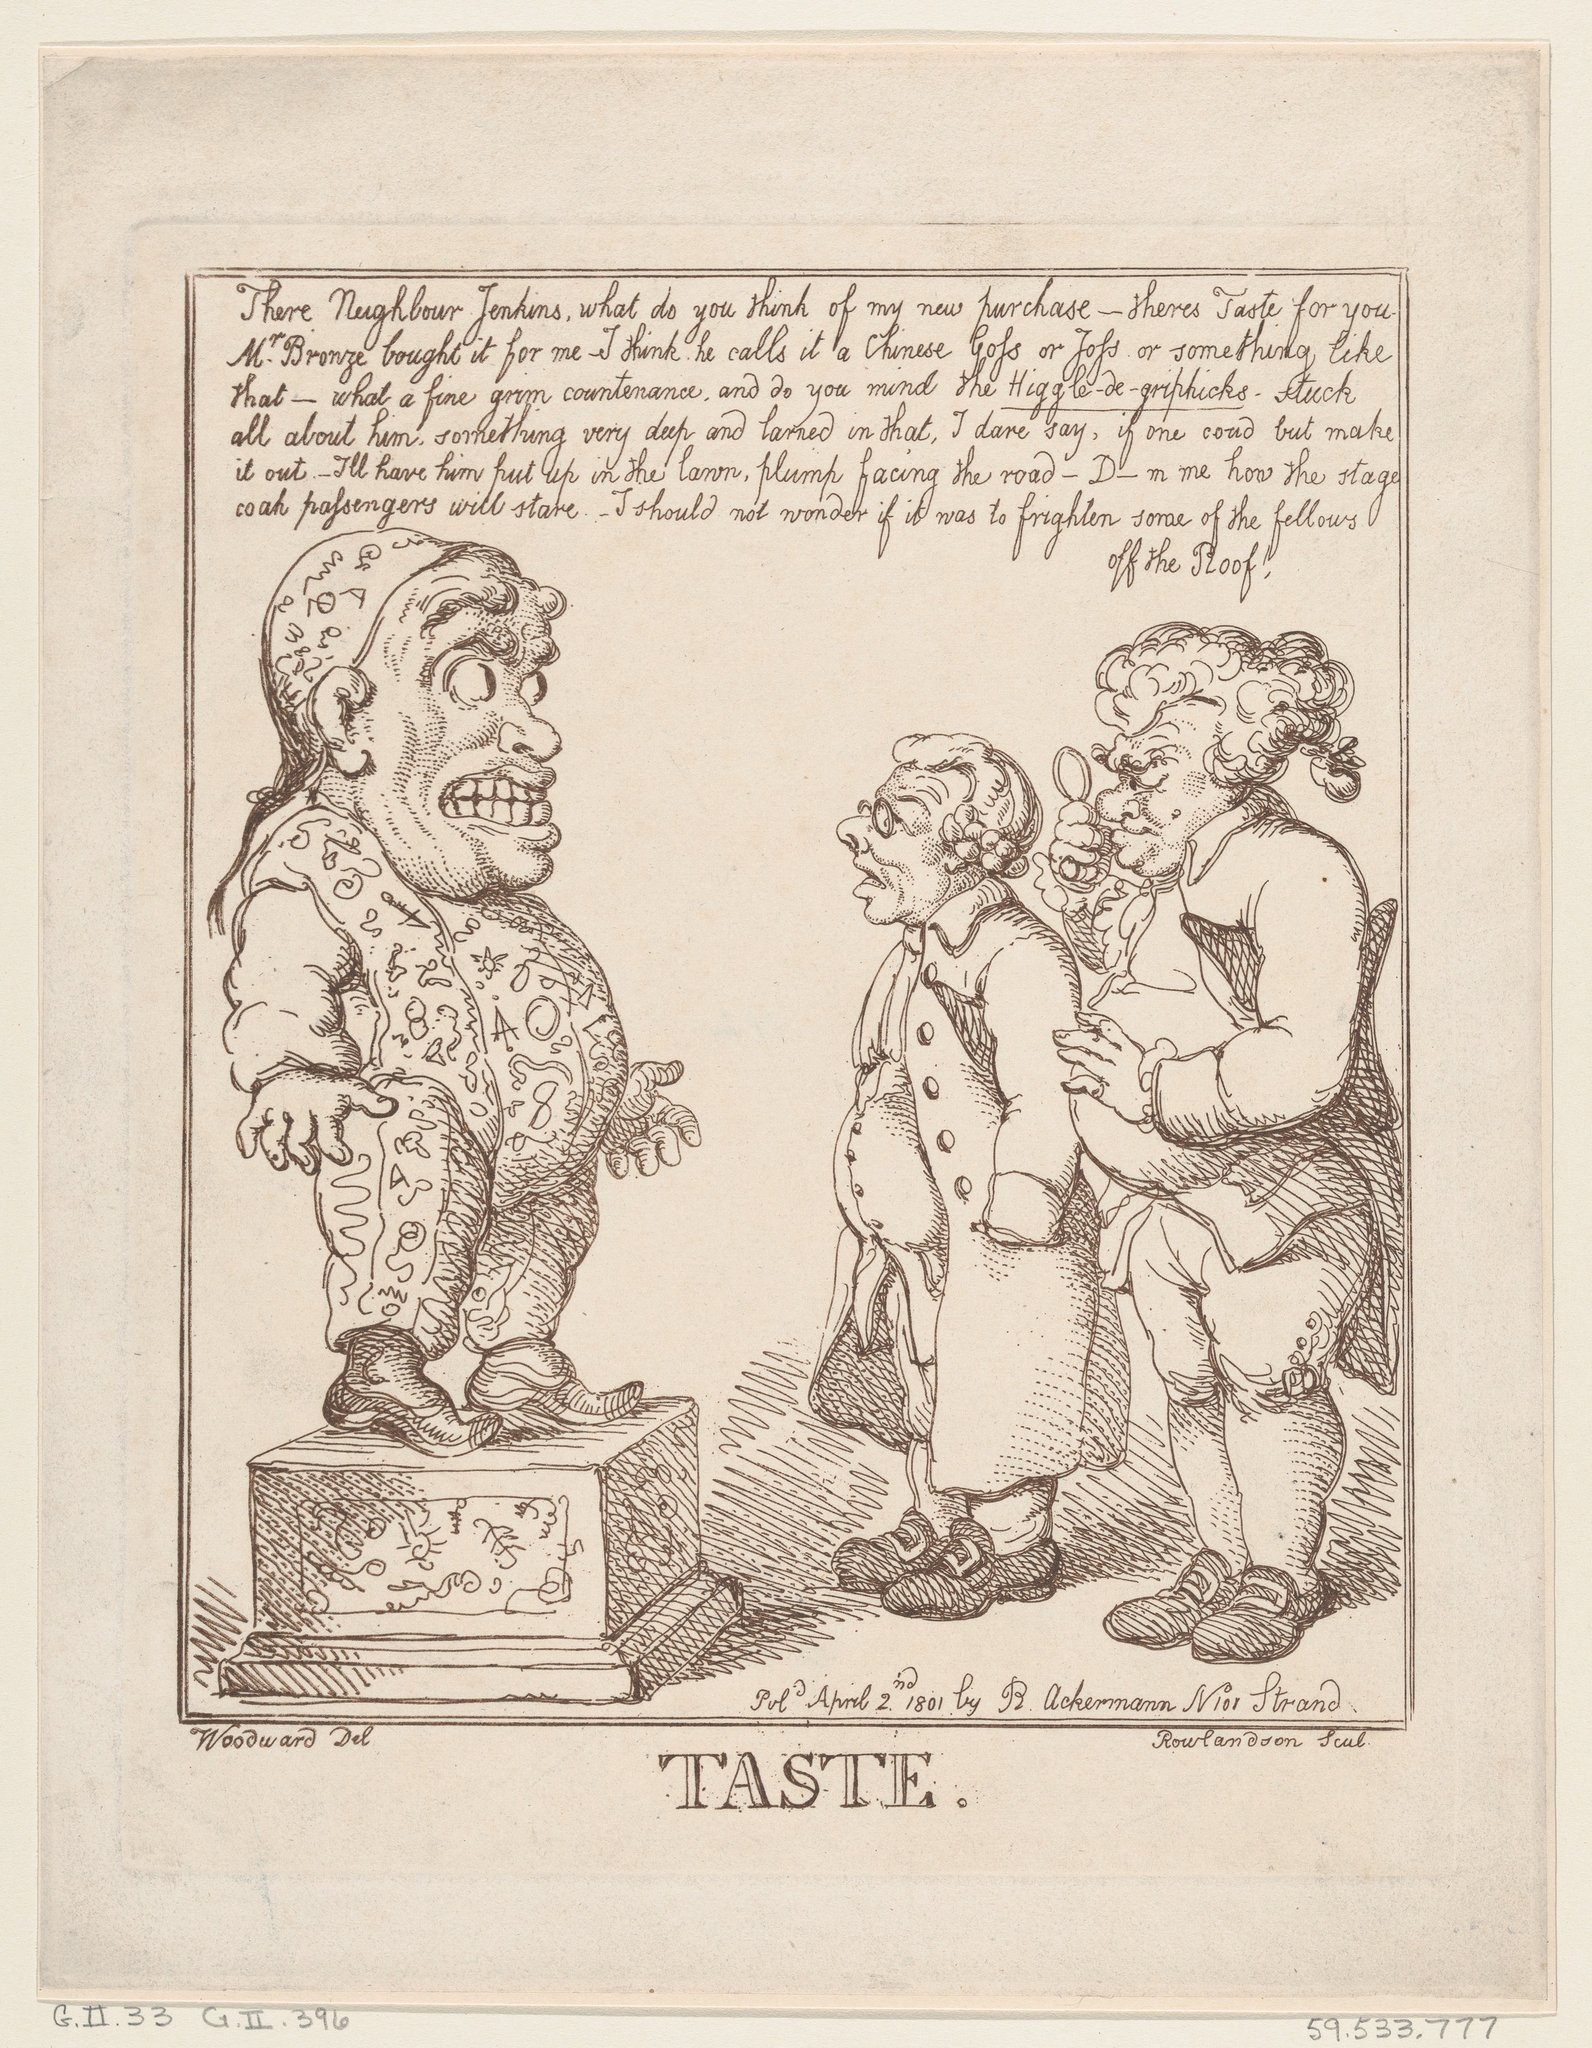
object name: print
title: Taste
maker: thomas rowlandson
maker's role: artist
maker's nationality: british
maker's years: 1757-1827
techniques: etching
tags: men